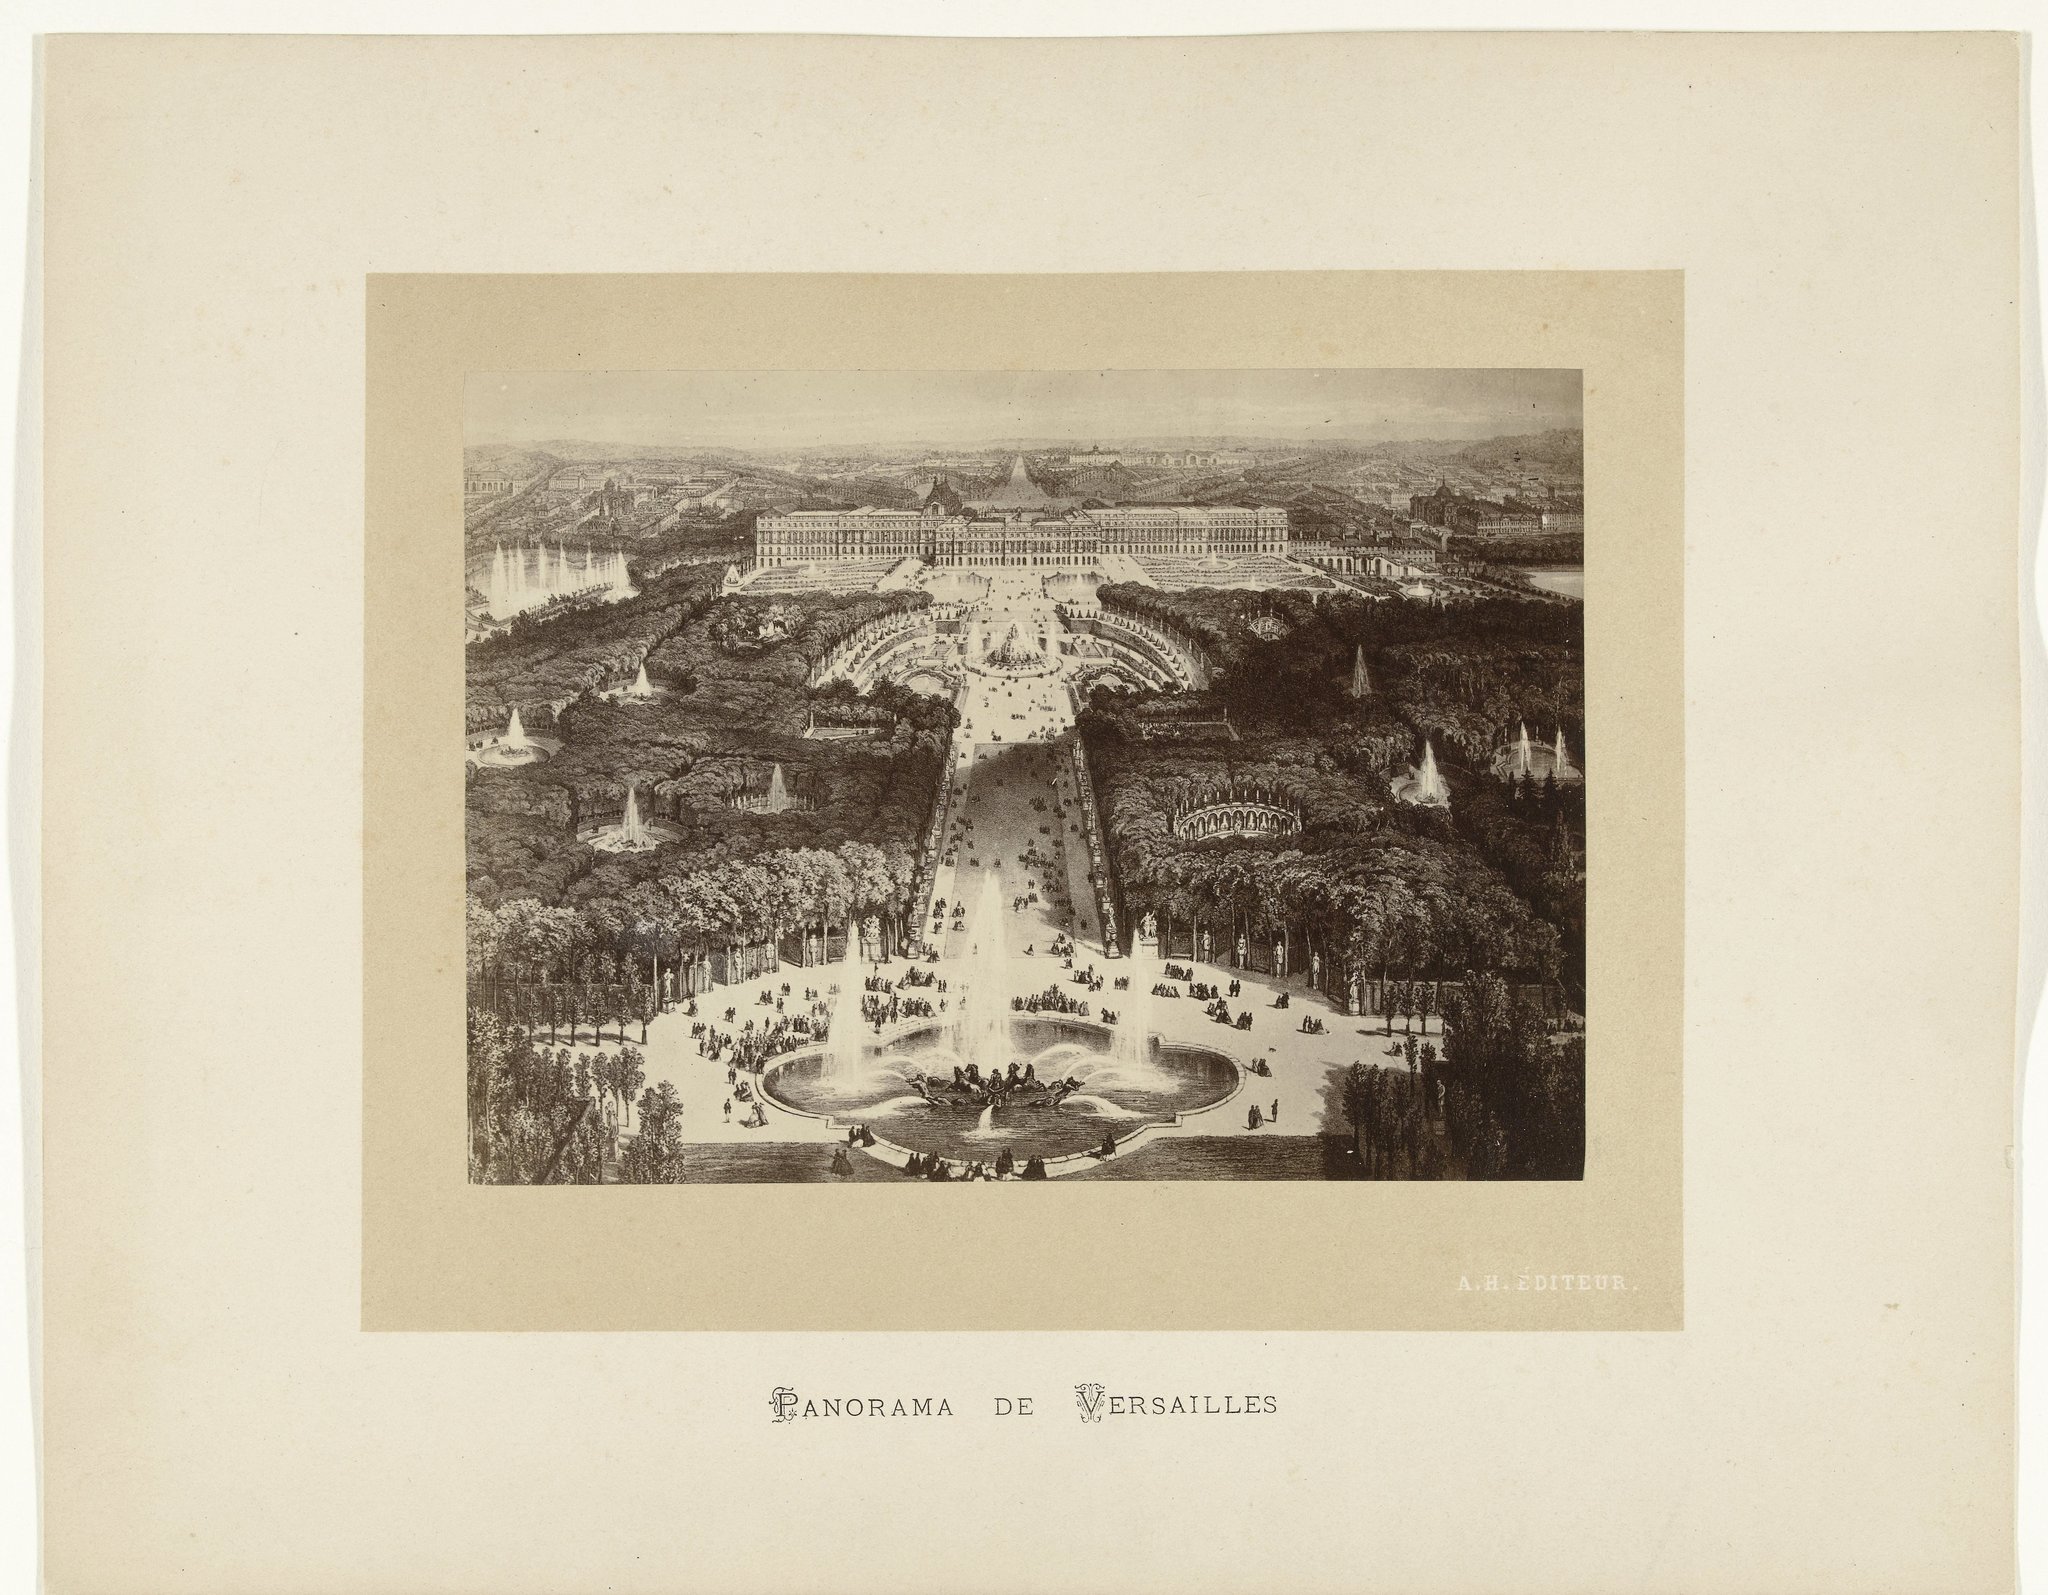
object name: reproduction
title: Panorama de Versailles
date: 1860-1890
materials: cardboard, paper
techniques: albumen print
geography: france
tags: palace, french or architectonic garden; formal garden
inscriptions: inscription: ‘uit top Frk/ 2003’, inscription: ‘A.H. Éditeur’